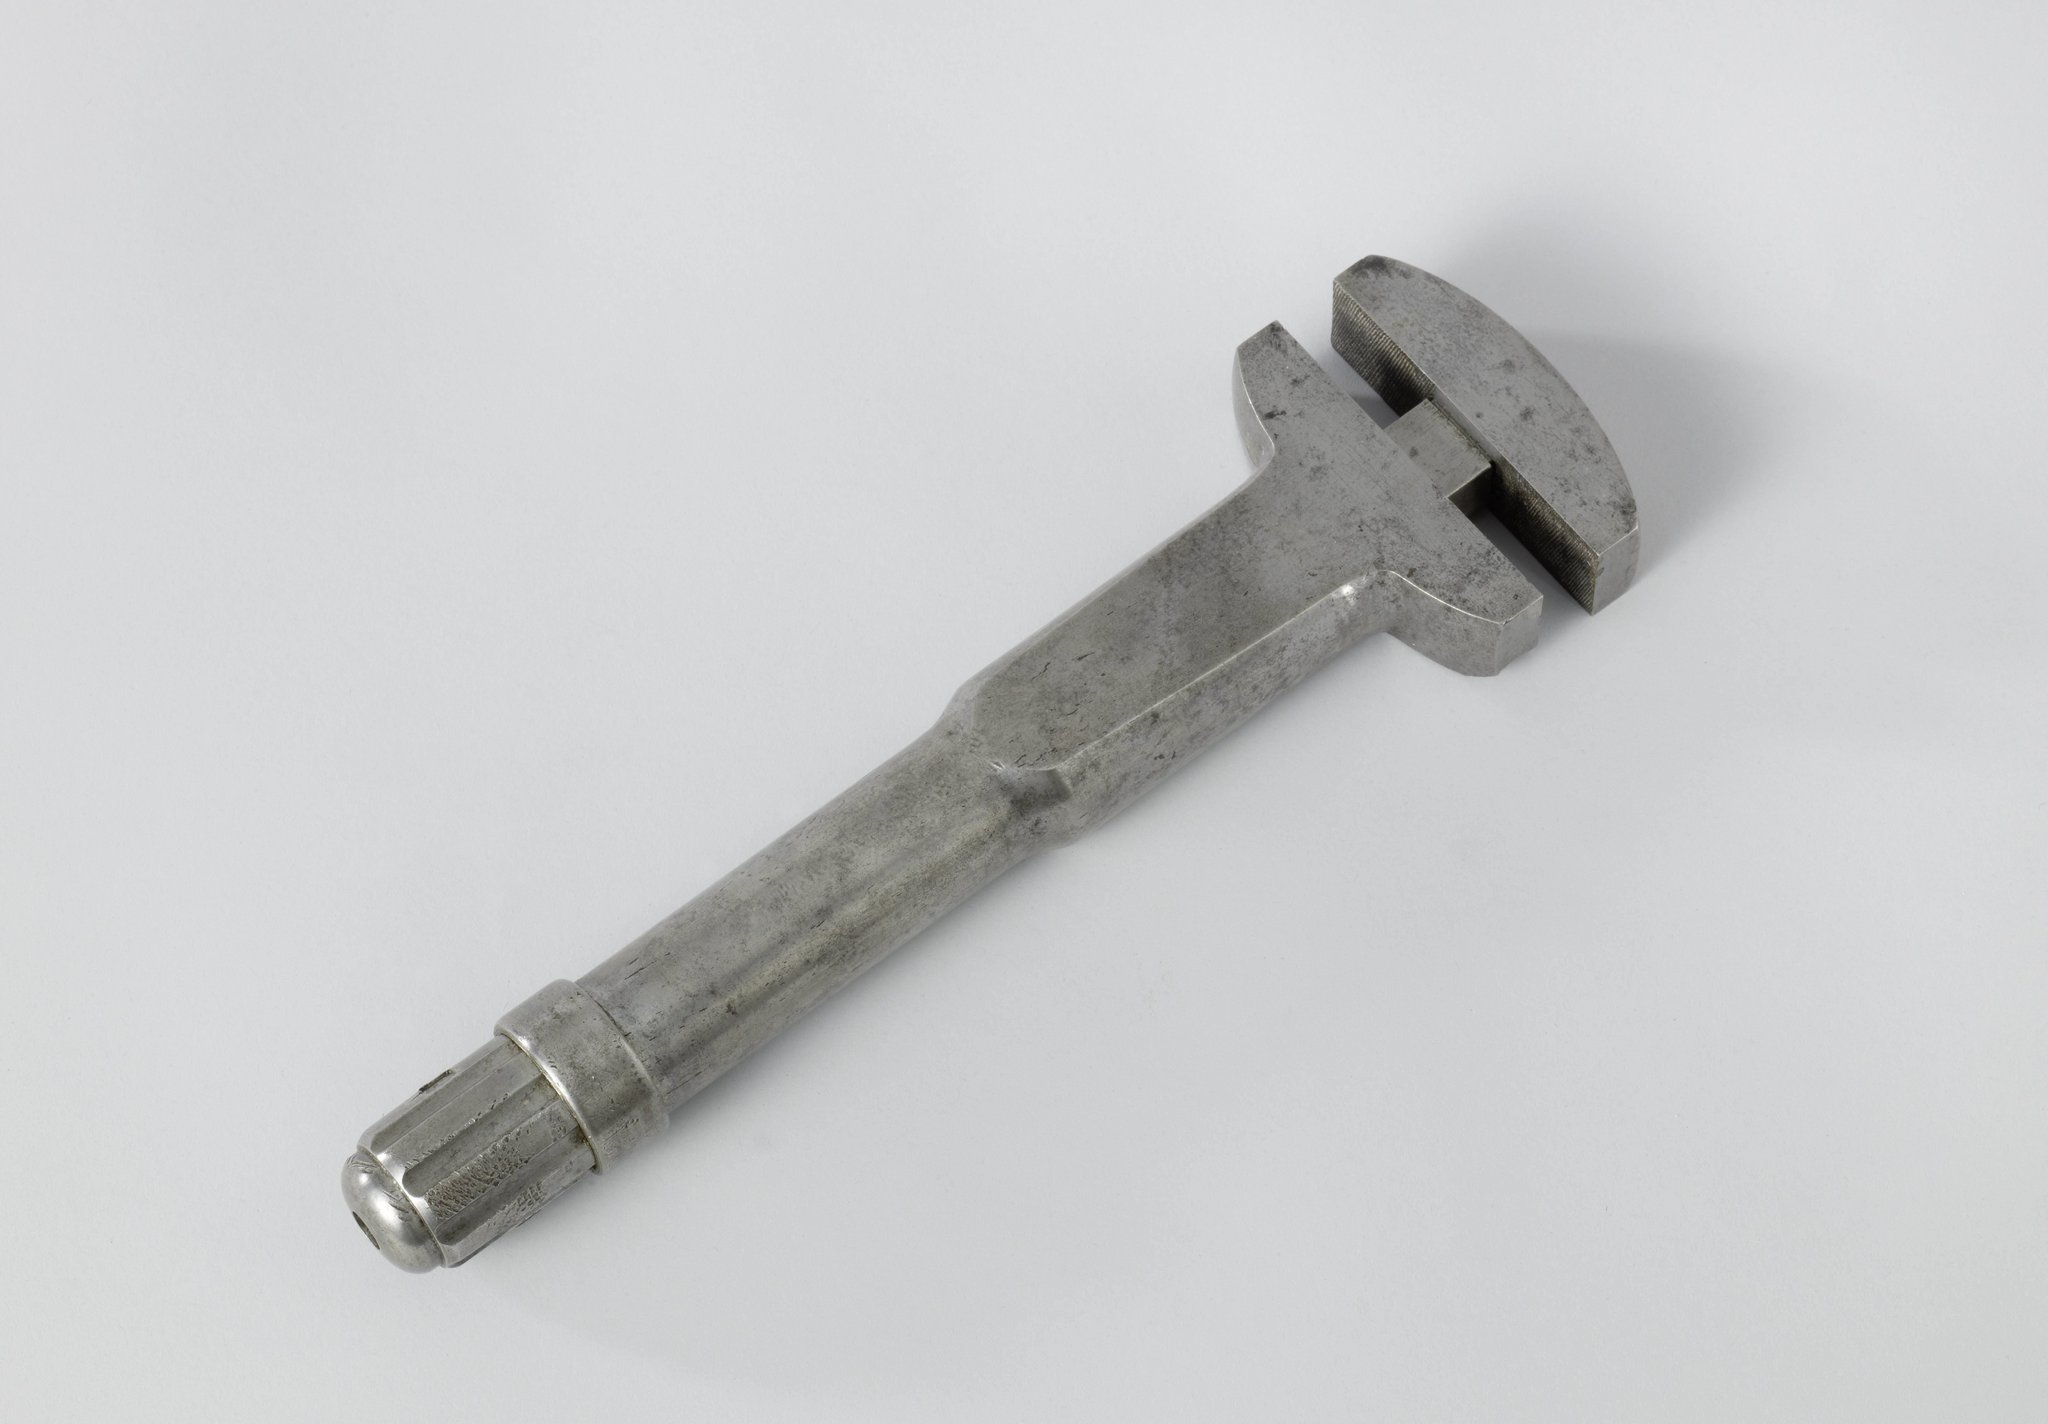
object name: demonstration model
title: Screw Spanner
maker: d. van den bosch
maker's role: print maker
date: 1855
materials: iron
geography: hellevoetsluis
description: Prototype van een schroefsleutel met maximum opening van zes centimeter. Bek naar beide kanten. D.m.v. een draaiend handvat kan de sleutel geopend en gesloten worden (sluiten door in de richting van de klok te draaien). Schaal 1:1.